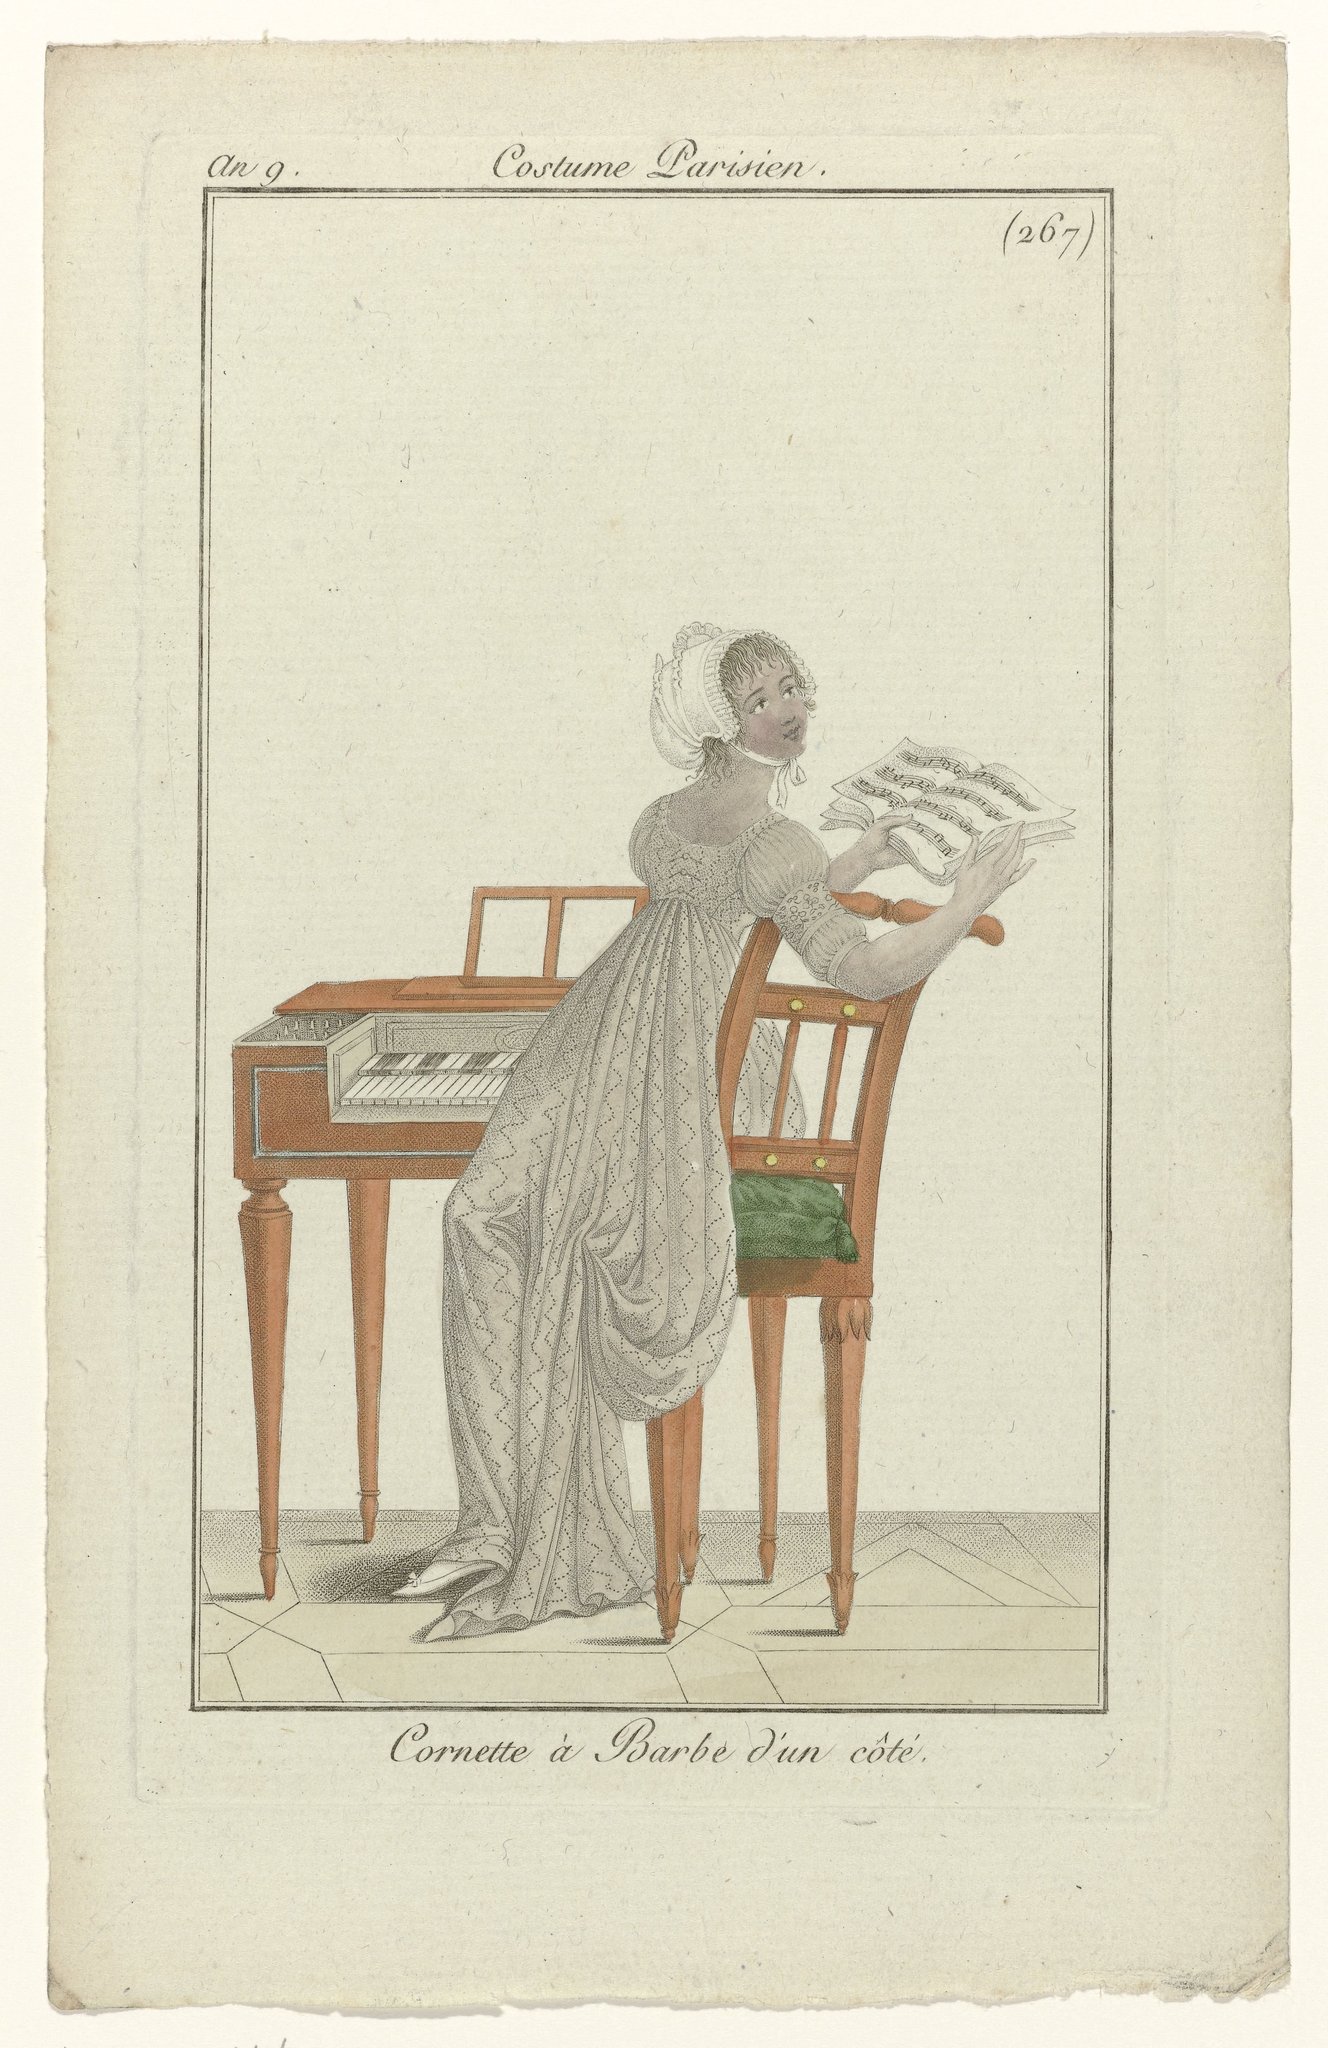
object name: fashion print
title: Journal des Dames et des Modes, Costume Parisien, 21 déc. 1800, An 9 (267) : Cornette à Barb (...)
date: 1800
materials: paper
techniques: engraving, hand coloring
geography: paris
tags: notation of music, head-gear (cornette) (+ women's clothes), fashion plates, shoes, sandals (+ women's clothes), dress, gown (+ women's clothes), chair, pianoforte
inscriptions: caption: ‘Cornette à Barbe d'un côté’, title: ‘Costume Parisien.’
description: Vrouw, op de rug gezien, zittend voor een pianoforte. Bladmuziek in de handen. Japon met een motief van verticale zig-zag lijnen. 'Cornette' met een 'barbe' (slip) aan de zijkant. platte schoen met puntige neus. De prent maakt deel uit van het modetijdschrift Journal des Dames et des Modes, uitgegeven door Pierre de la Mésangère, Parijs, 1797-1839.